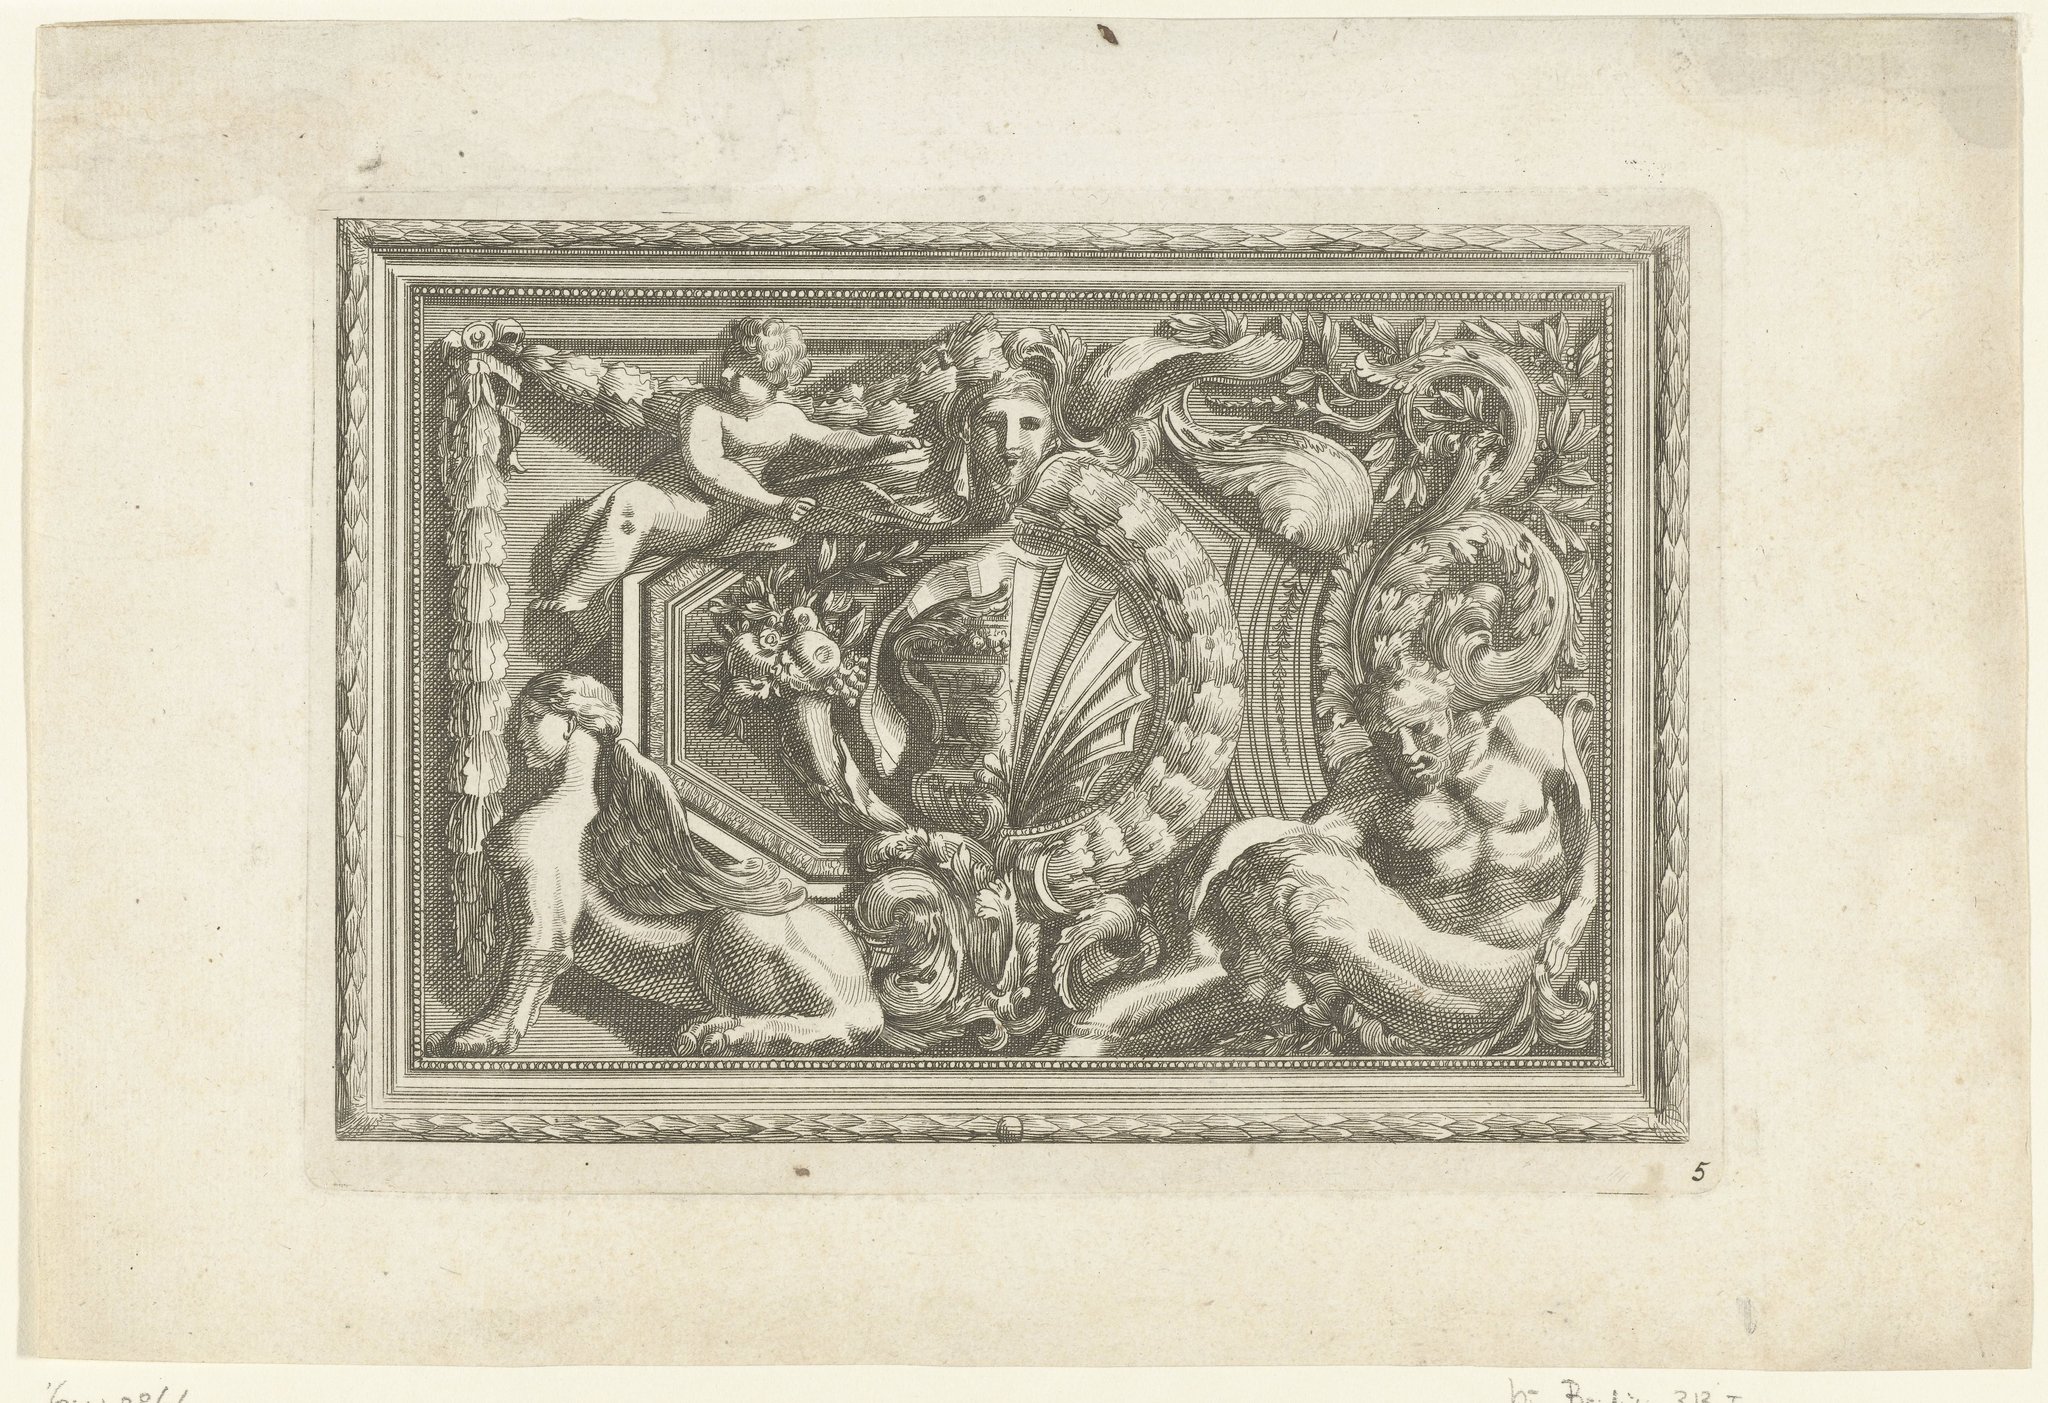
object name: print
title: Ornamentele panelen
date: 1696-1717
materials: paper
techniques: etching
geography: netherlands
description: Links een achthoekig paneel met een vaas en een hoorn des overvloeds, ondersteund door een sfinx; rechts een lauwerkrans, een sater en bladranken.